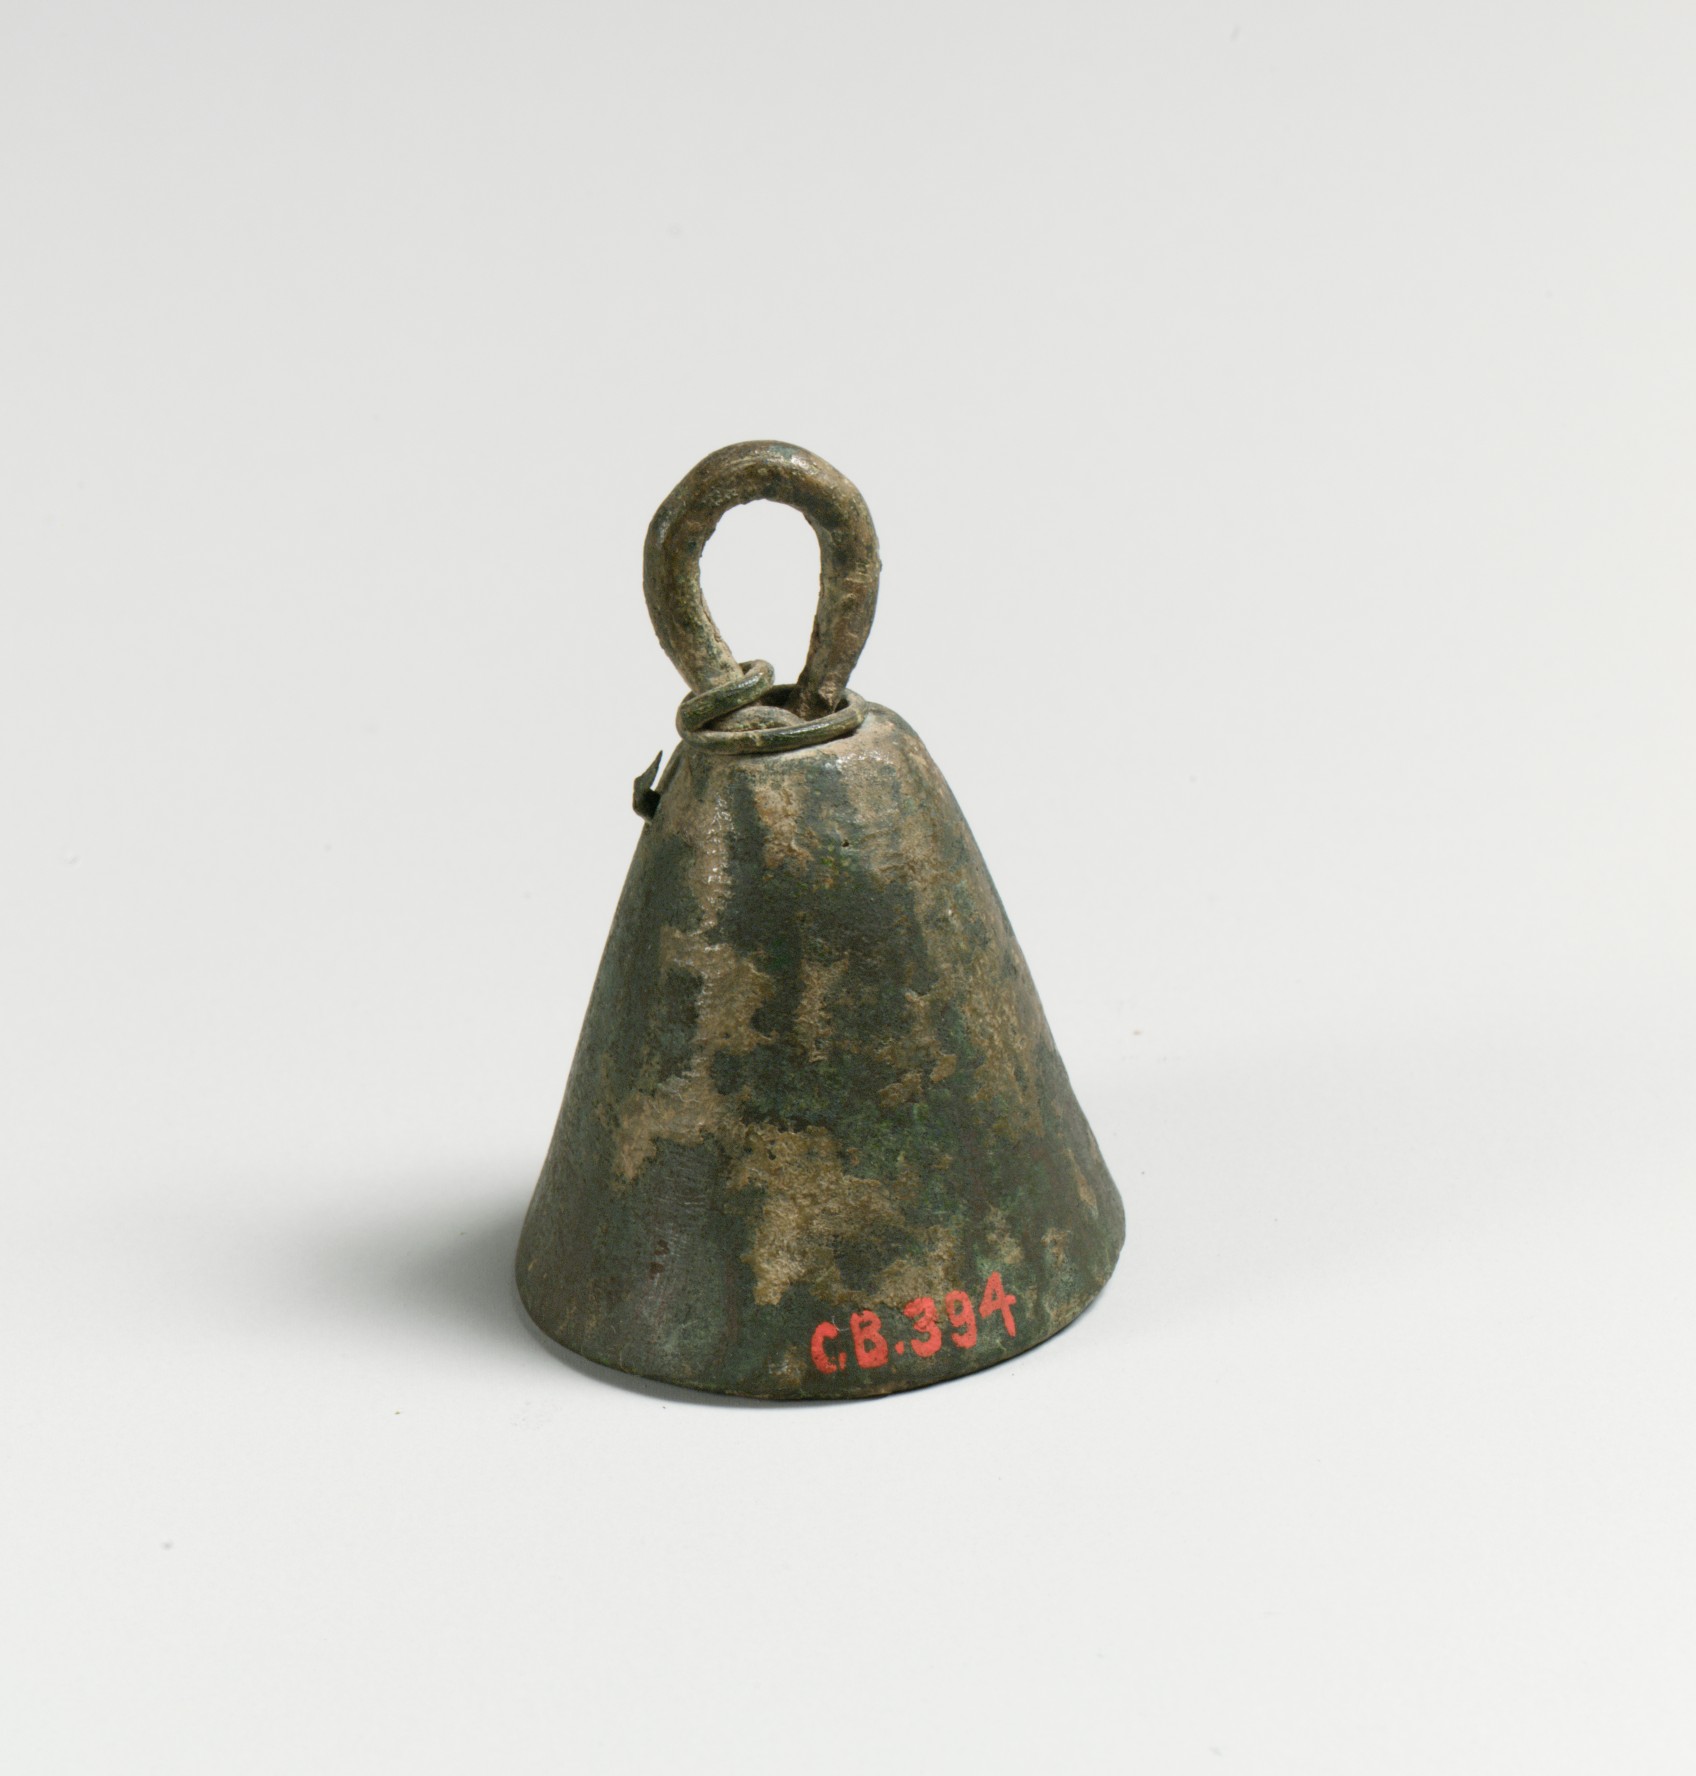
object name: bell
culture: cypriot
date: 400-301 BCE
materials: bronze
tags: musical instruments